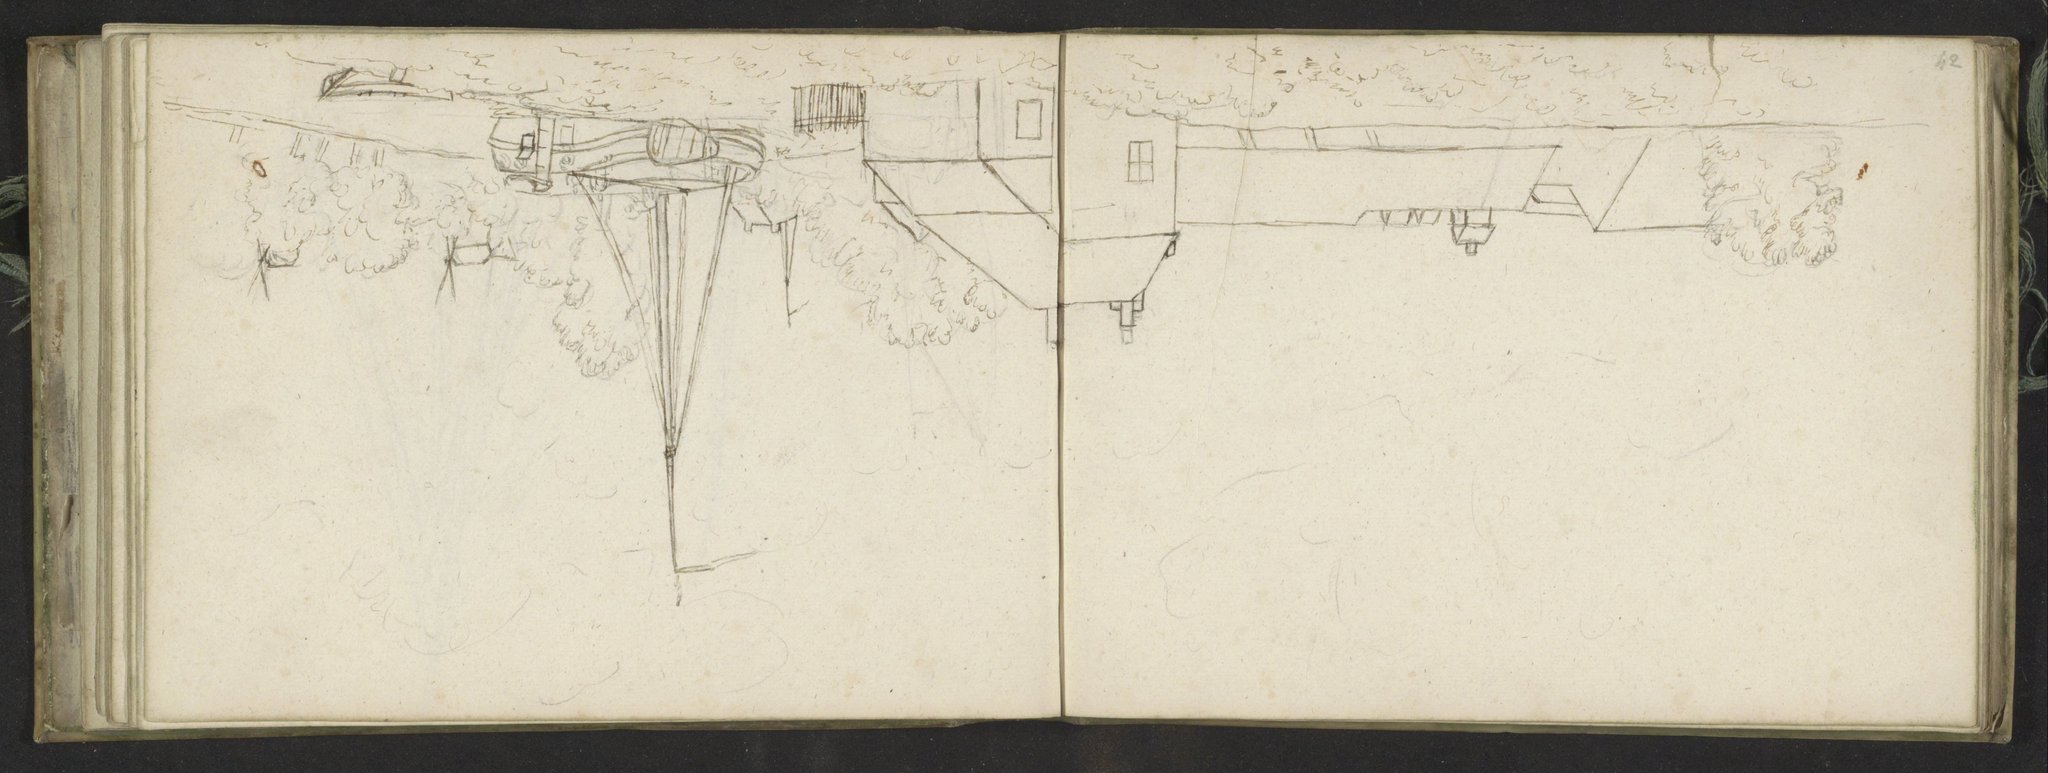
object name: sketchbook leaf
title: Riviergezicht met een afgemeerd zeilschip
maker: martinus schouman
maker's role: draughtsman, painter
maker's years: 1770-1848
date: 1780-1848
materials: ink, paper, pencil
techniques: pen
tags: river, windmill in landscape, farm (building)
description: Aan de ene zijde van de rivier molens en aan de andere zijde een boerderij. Blad 41 verso en 42 recto uit een schetsboek met 53 bladen.